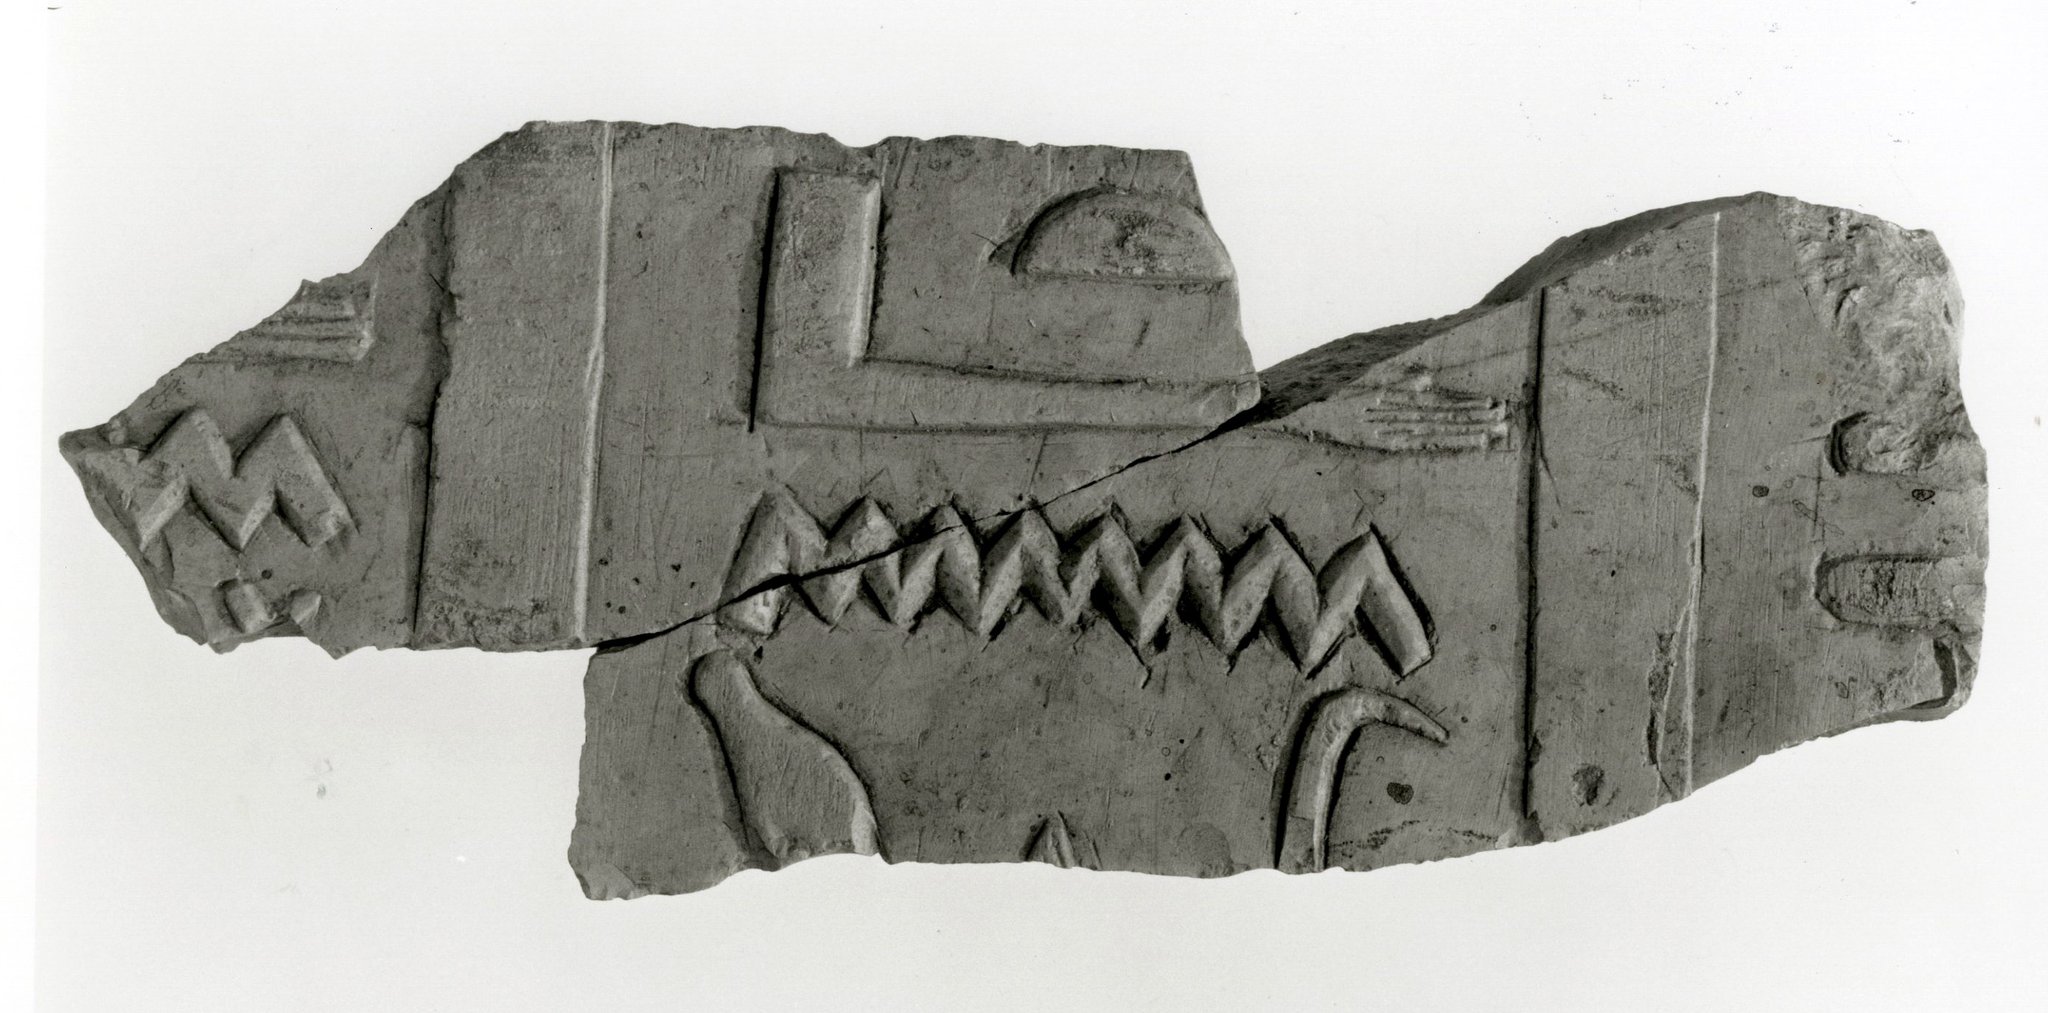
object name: relief, tomb of nespekashuty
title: Raised relief fragment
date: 664-610 BCE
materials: limestone, varnish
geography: egypt